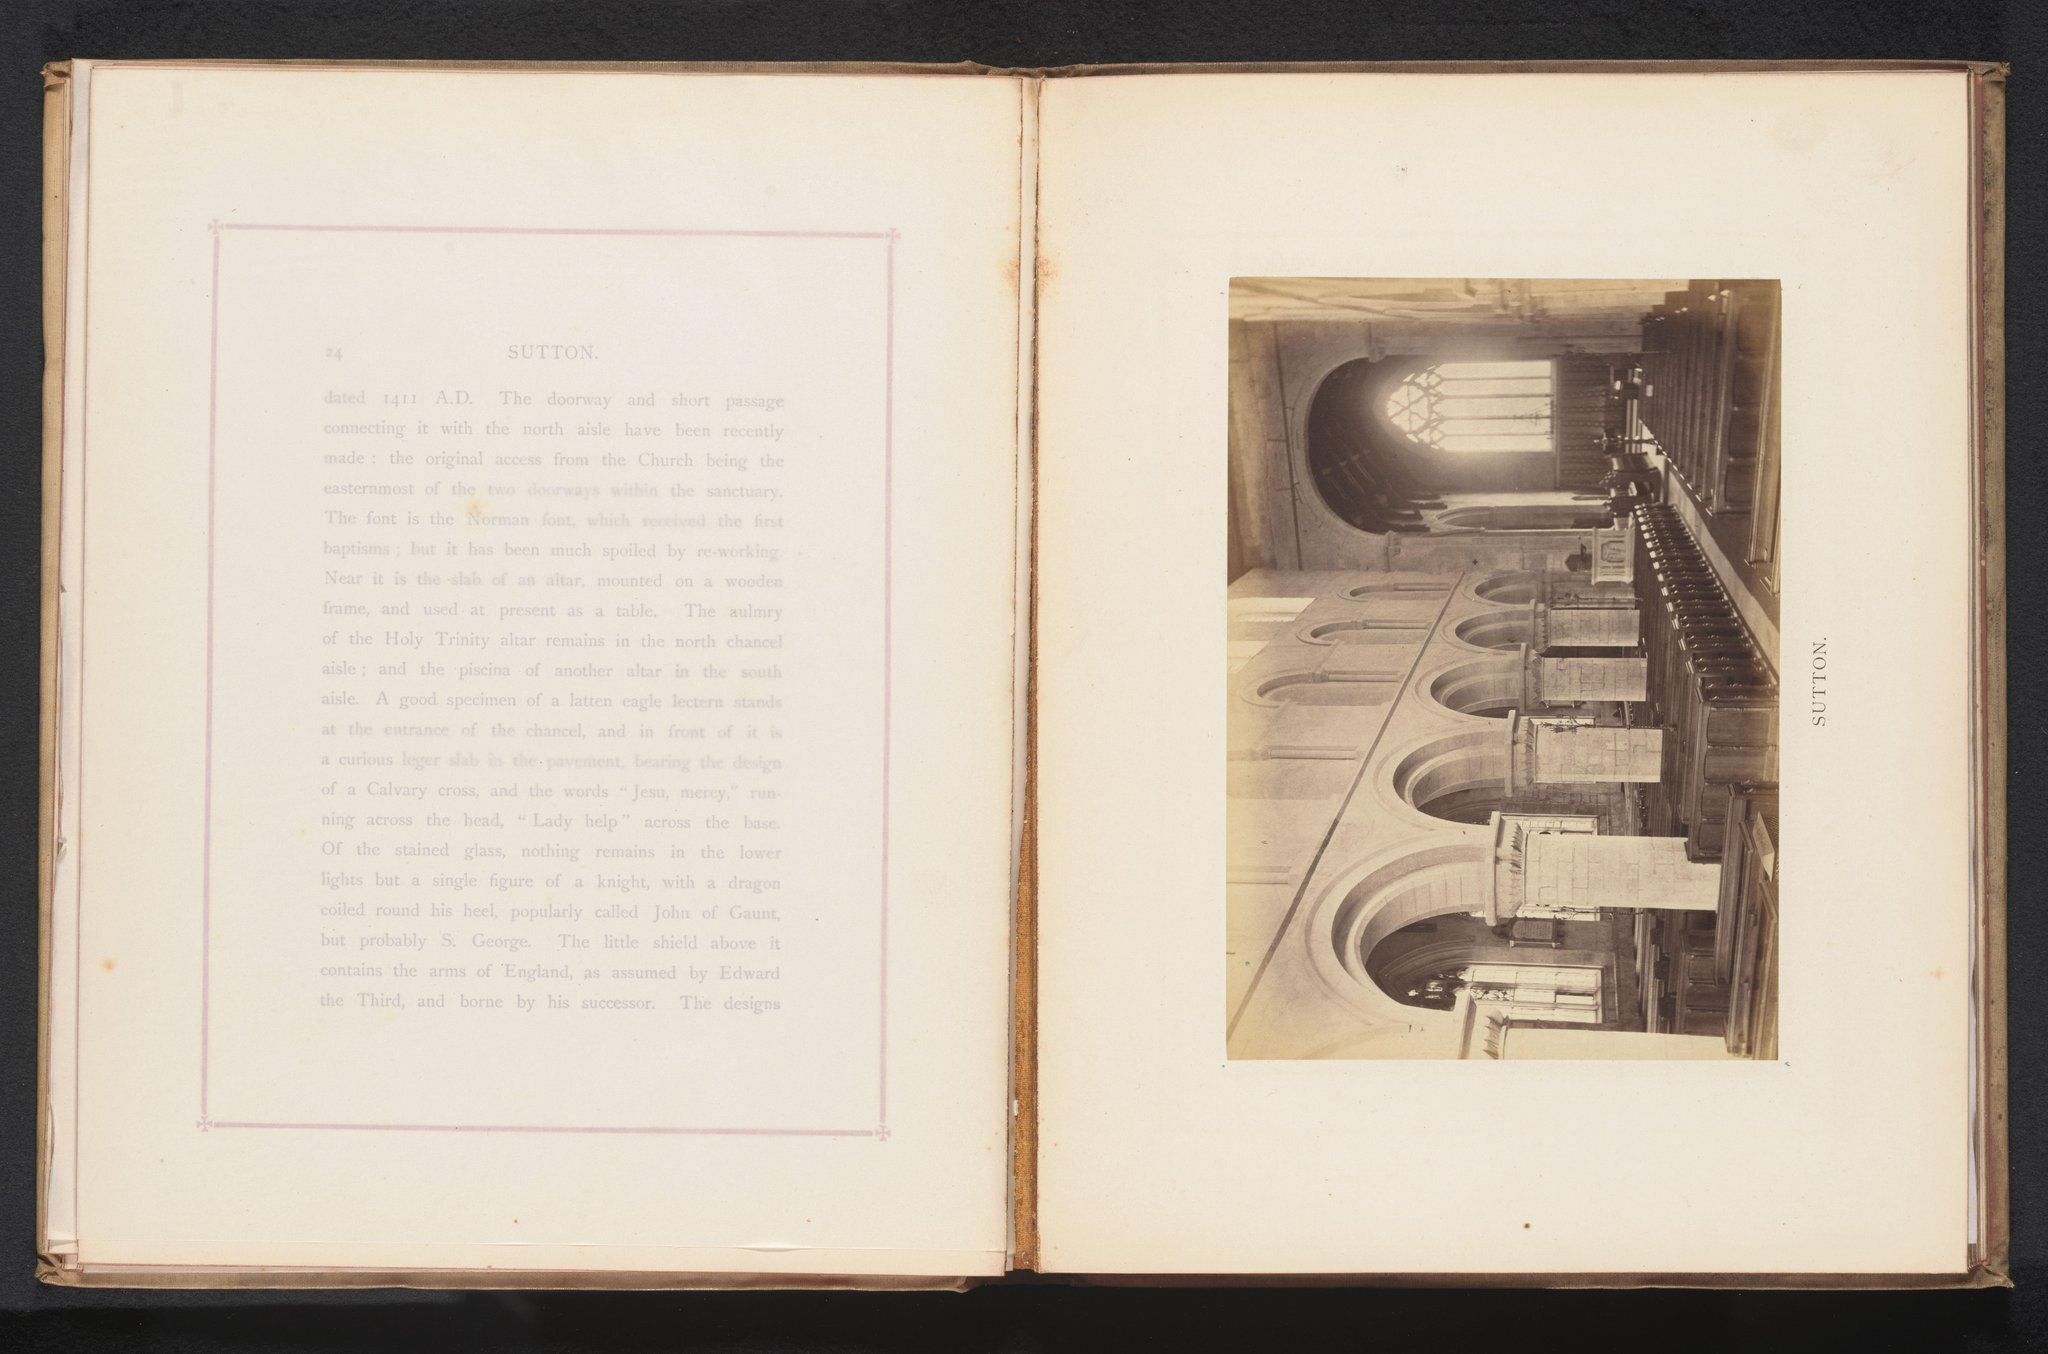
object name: page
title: Sutton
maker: Anonymous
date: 1858-1869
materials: photographic support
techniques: albumen print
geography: saint mary's church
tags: parts of church interior: aisle, interior of church